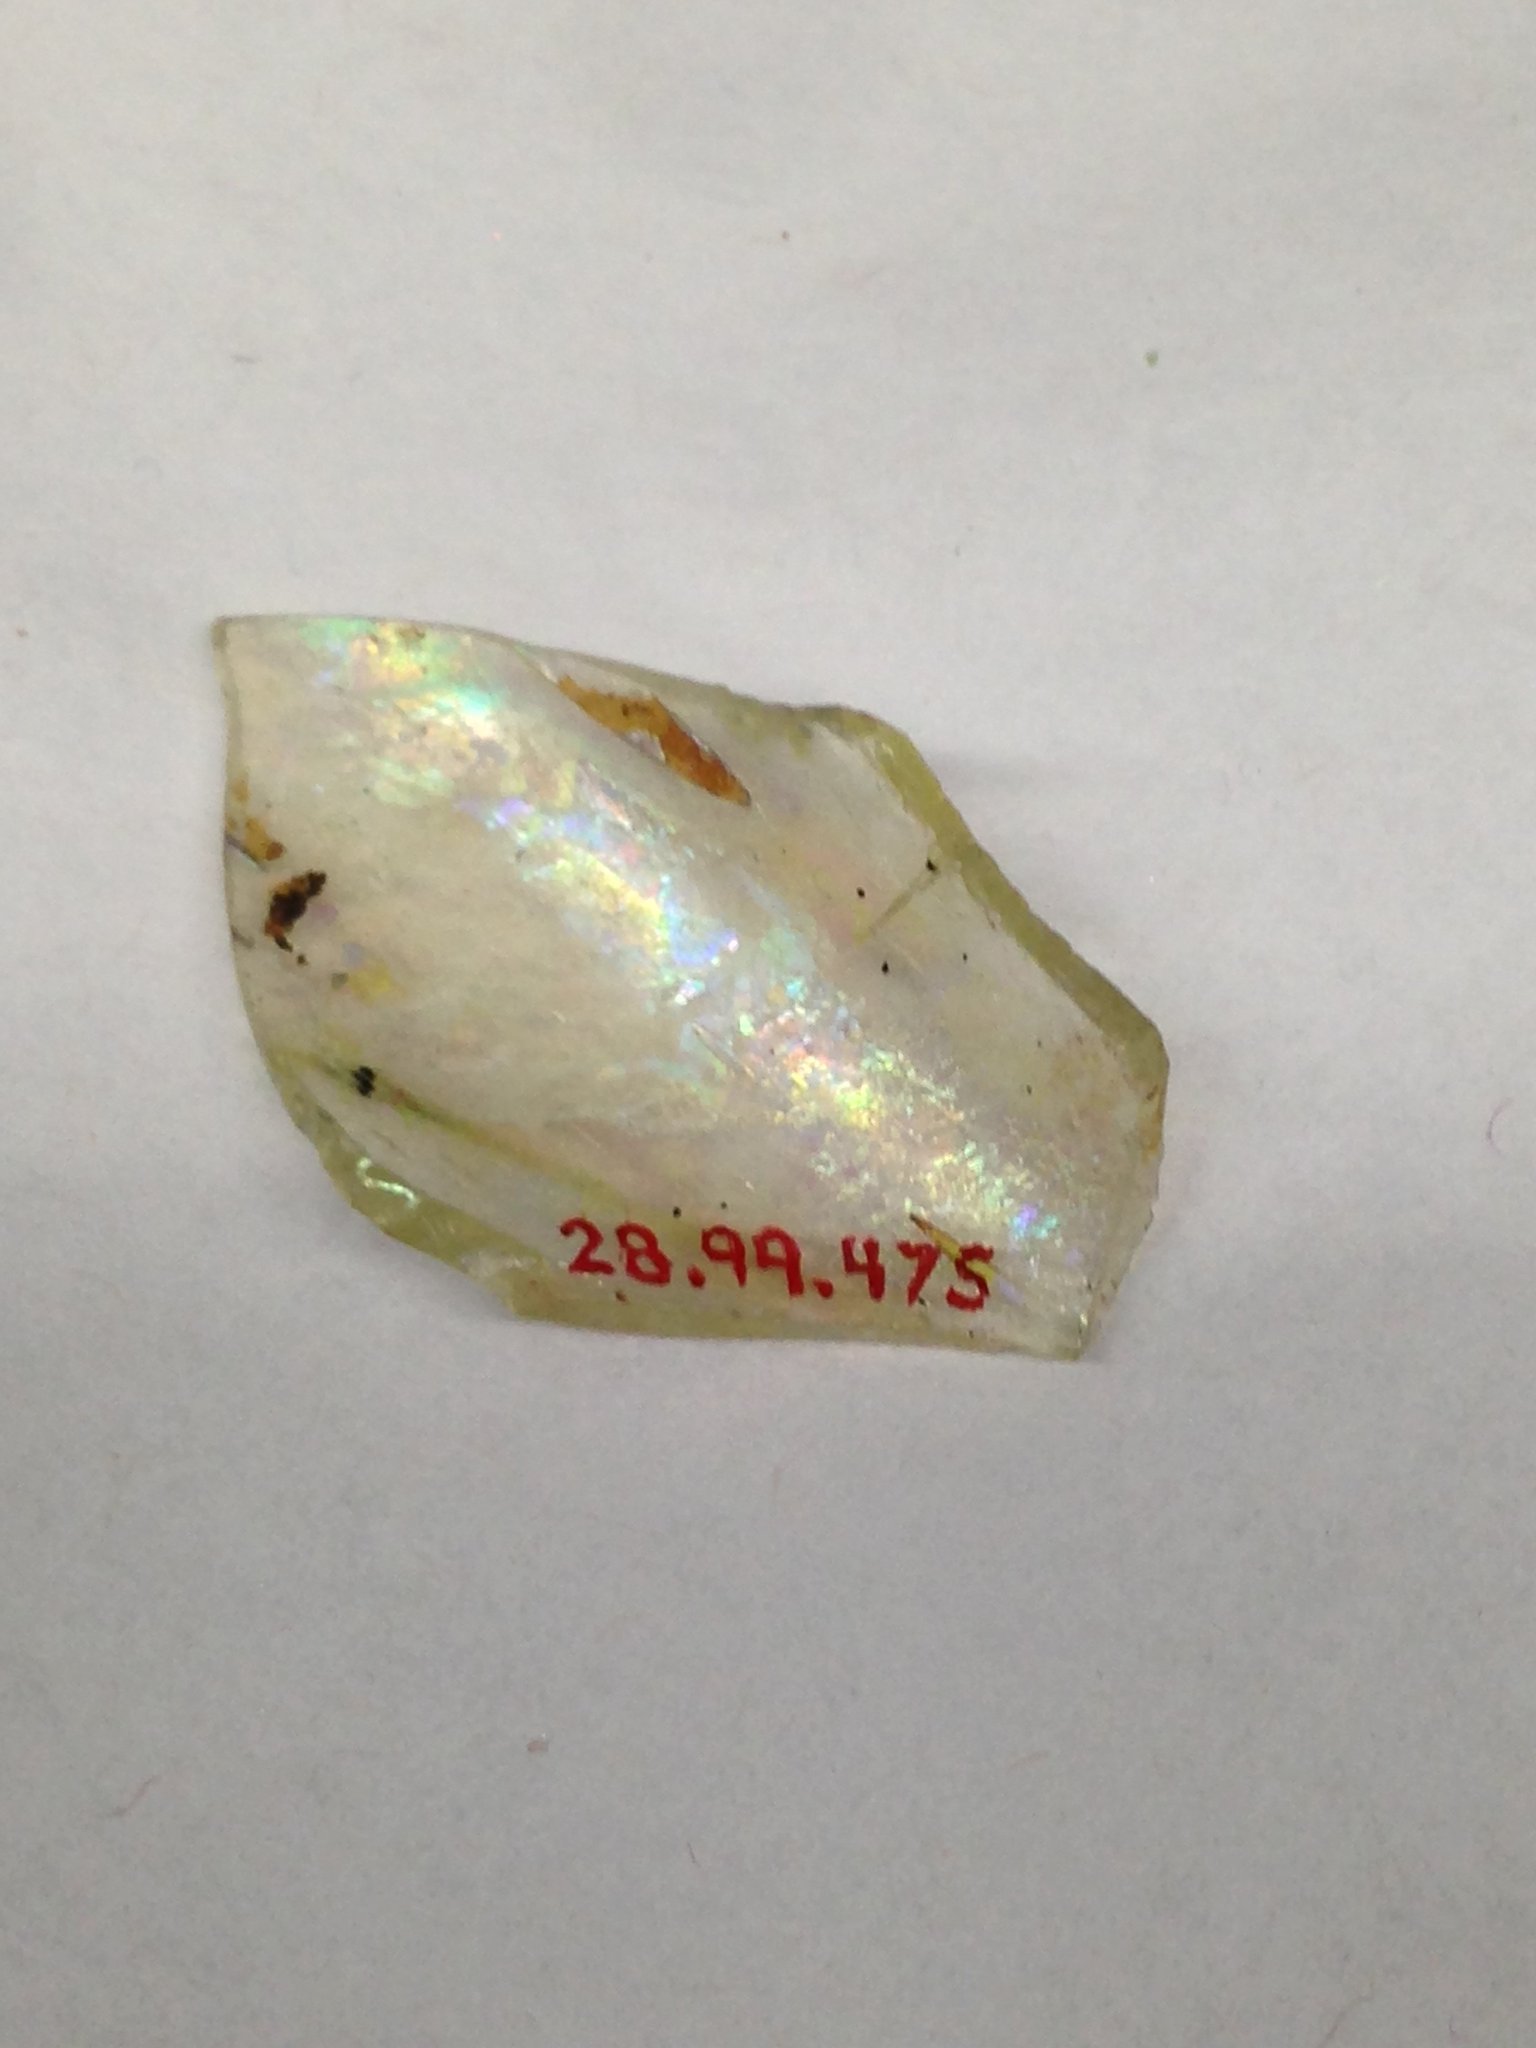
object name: fragment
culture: european or middle eastern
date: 1150-1250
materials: ceramic, glass